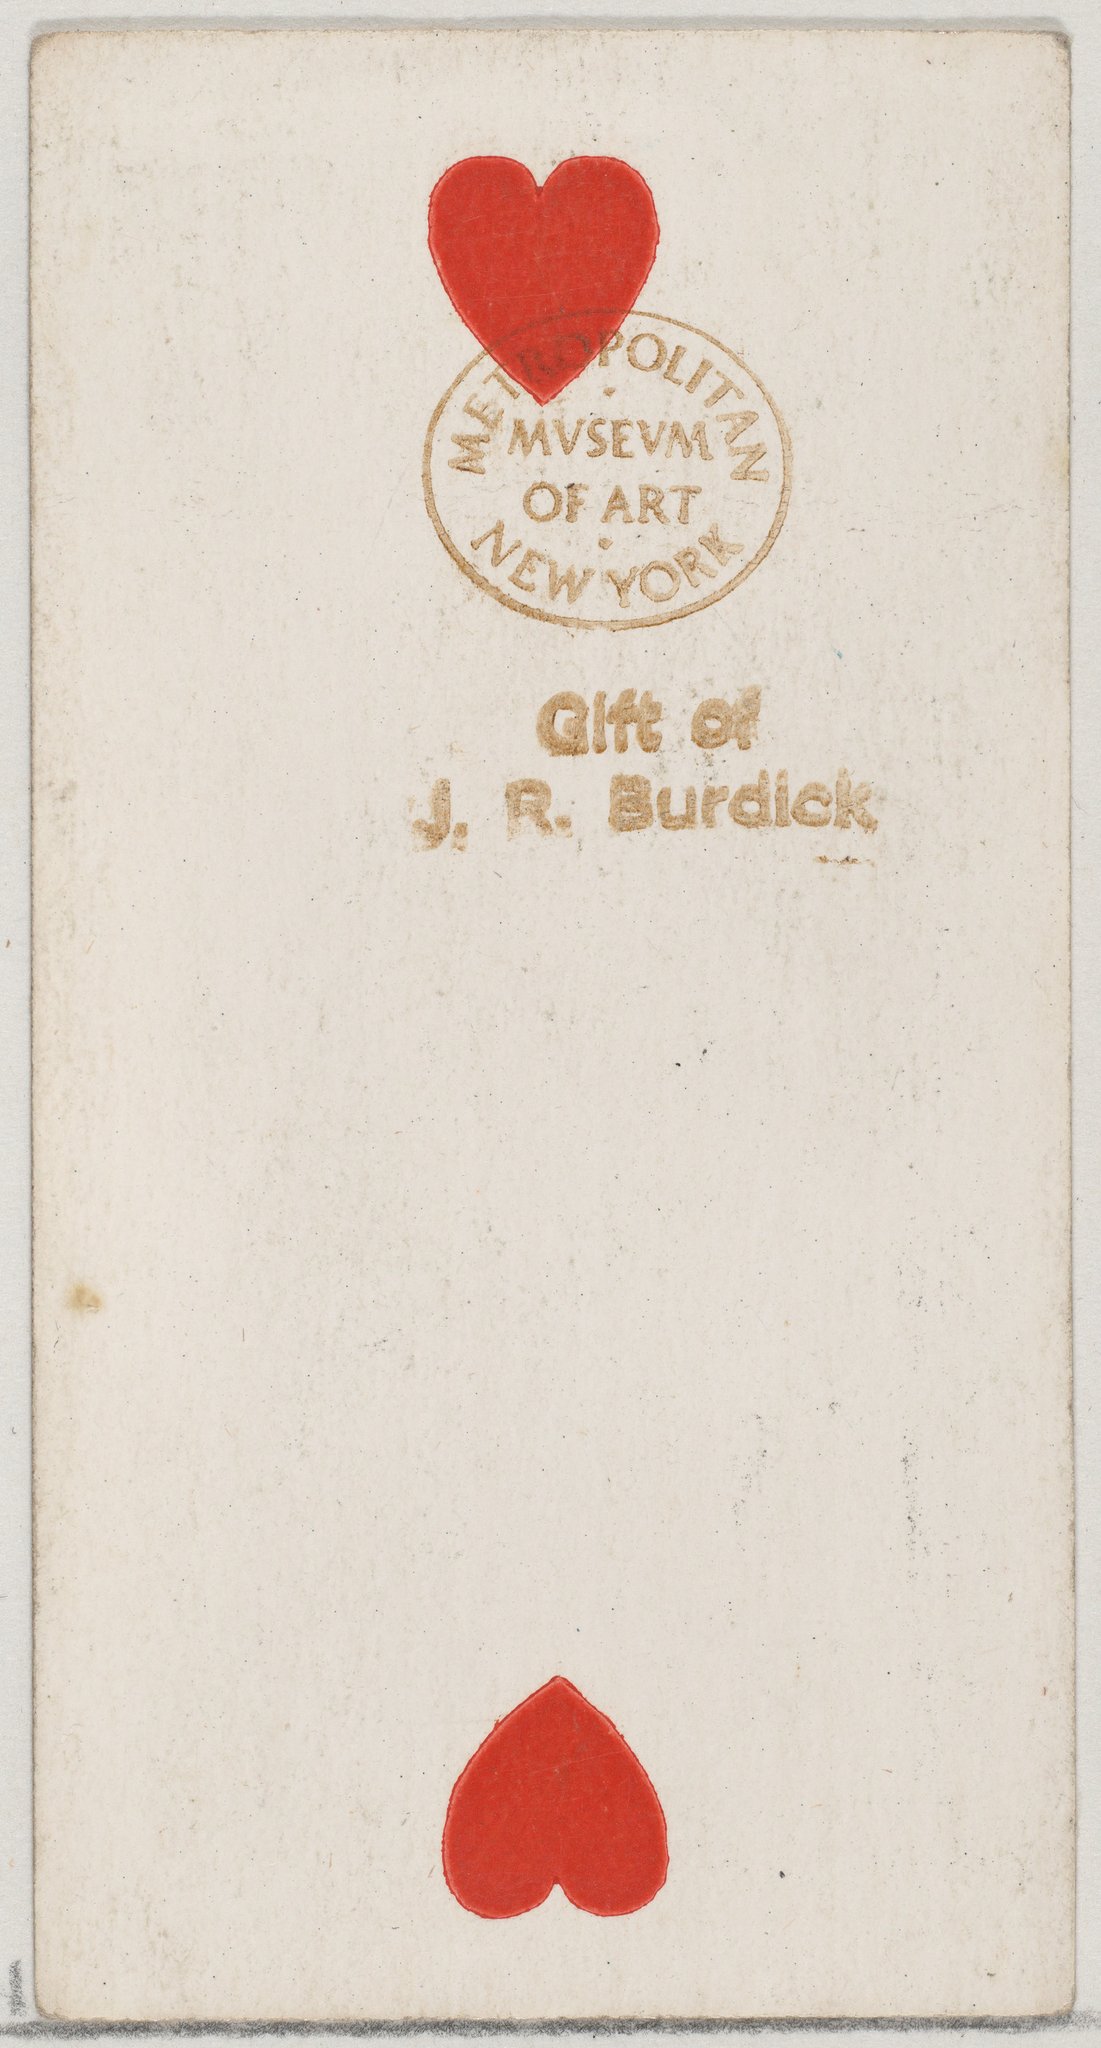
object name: print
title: Two Hearts, from the Playing Cards series (N84) to promote Turkish Cross-Cut Cigarettes for W. Duke, Sons and Co.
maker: w. duke, sons & co.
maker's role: publisher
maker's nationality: american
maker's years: 1870-1920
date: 1888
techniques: color lithograph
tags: playing cards